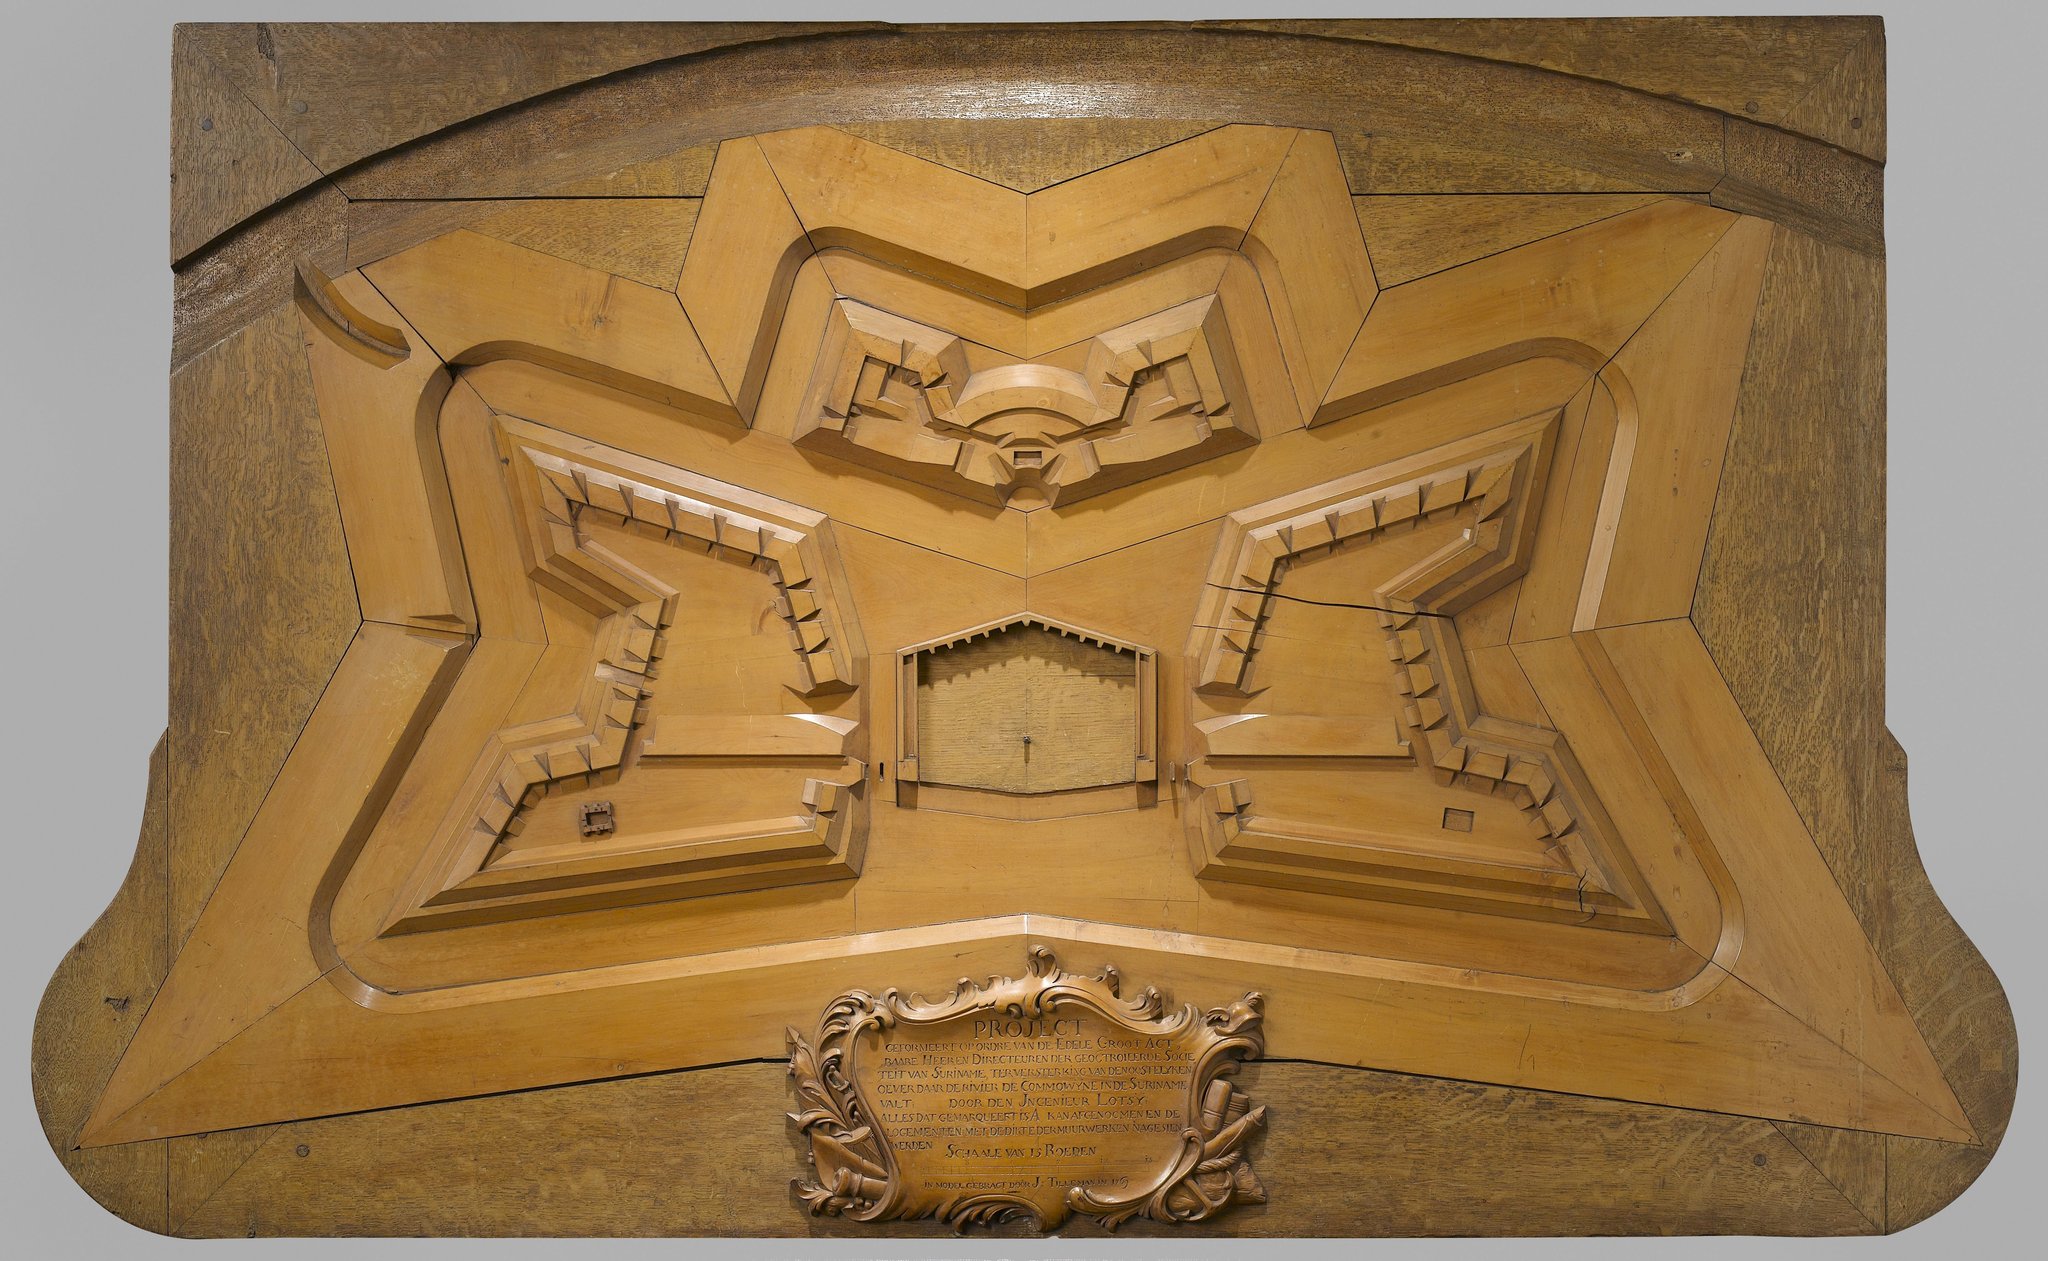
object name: relief sculpture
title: Two models of Fort Leyden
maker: j. tilleman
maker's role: houtsnijder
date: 1769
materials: wood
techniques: cutting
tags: fortress, suriname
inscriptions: inscription: ‘PROJECT GEFORMEERT OP ORDRE VAN DE EDELE GROOT AGT BAARE HEEREN DIRECTEUREN DER GEOCTROIEERDE SOCIETEIT VAN SURINAME, TER VERSTERKING VAN DEN OOSTELYKEN OEVER DAAR DE RIVIER DE COMMOWYNE IN DE SURINAME VALT. DOOR DEN INGENIEUR LOTSY ALLES DAT GEMARQUEERT IS KAN AFGENOOMEN EN DE LOGEMENTEN MET DE DIKTE DER MUURWERKEN NAGESIEN WERDEN/SCHAAL VAN 15 ROEDEN/IN MODEL GEBRAGT DOOR J. TILLEMAN 1769’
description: During the second half of the 18th century, ever more plantations arose along the Commewijne River in Suriname. Fort Leyden was built at the mouth of the river to protect the new settlements from attacks from the water. These wooden models were sent from the Netherlands to Suriname as examples for the construction of the stronghold.